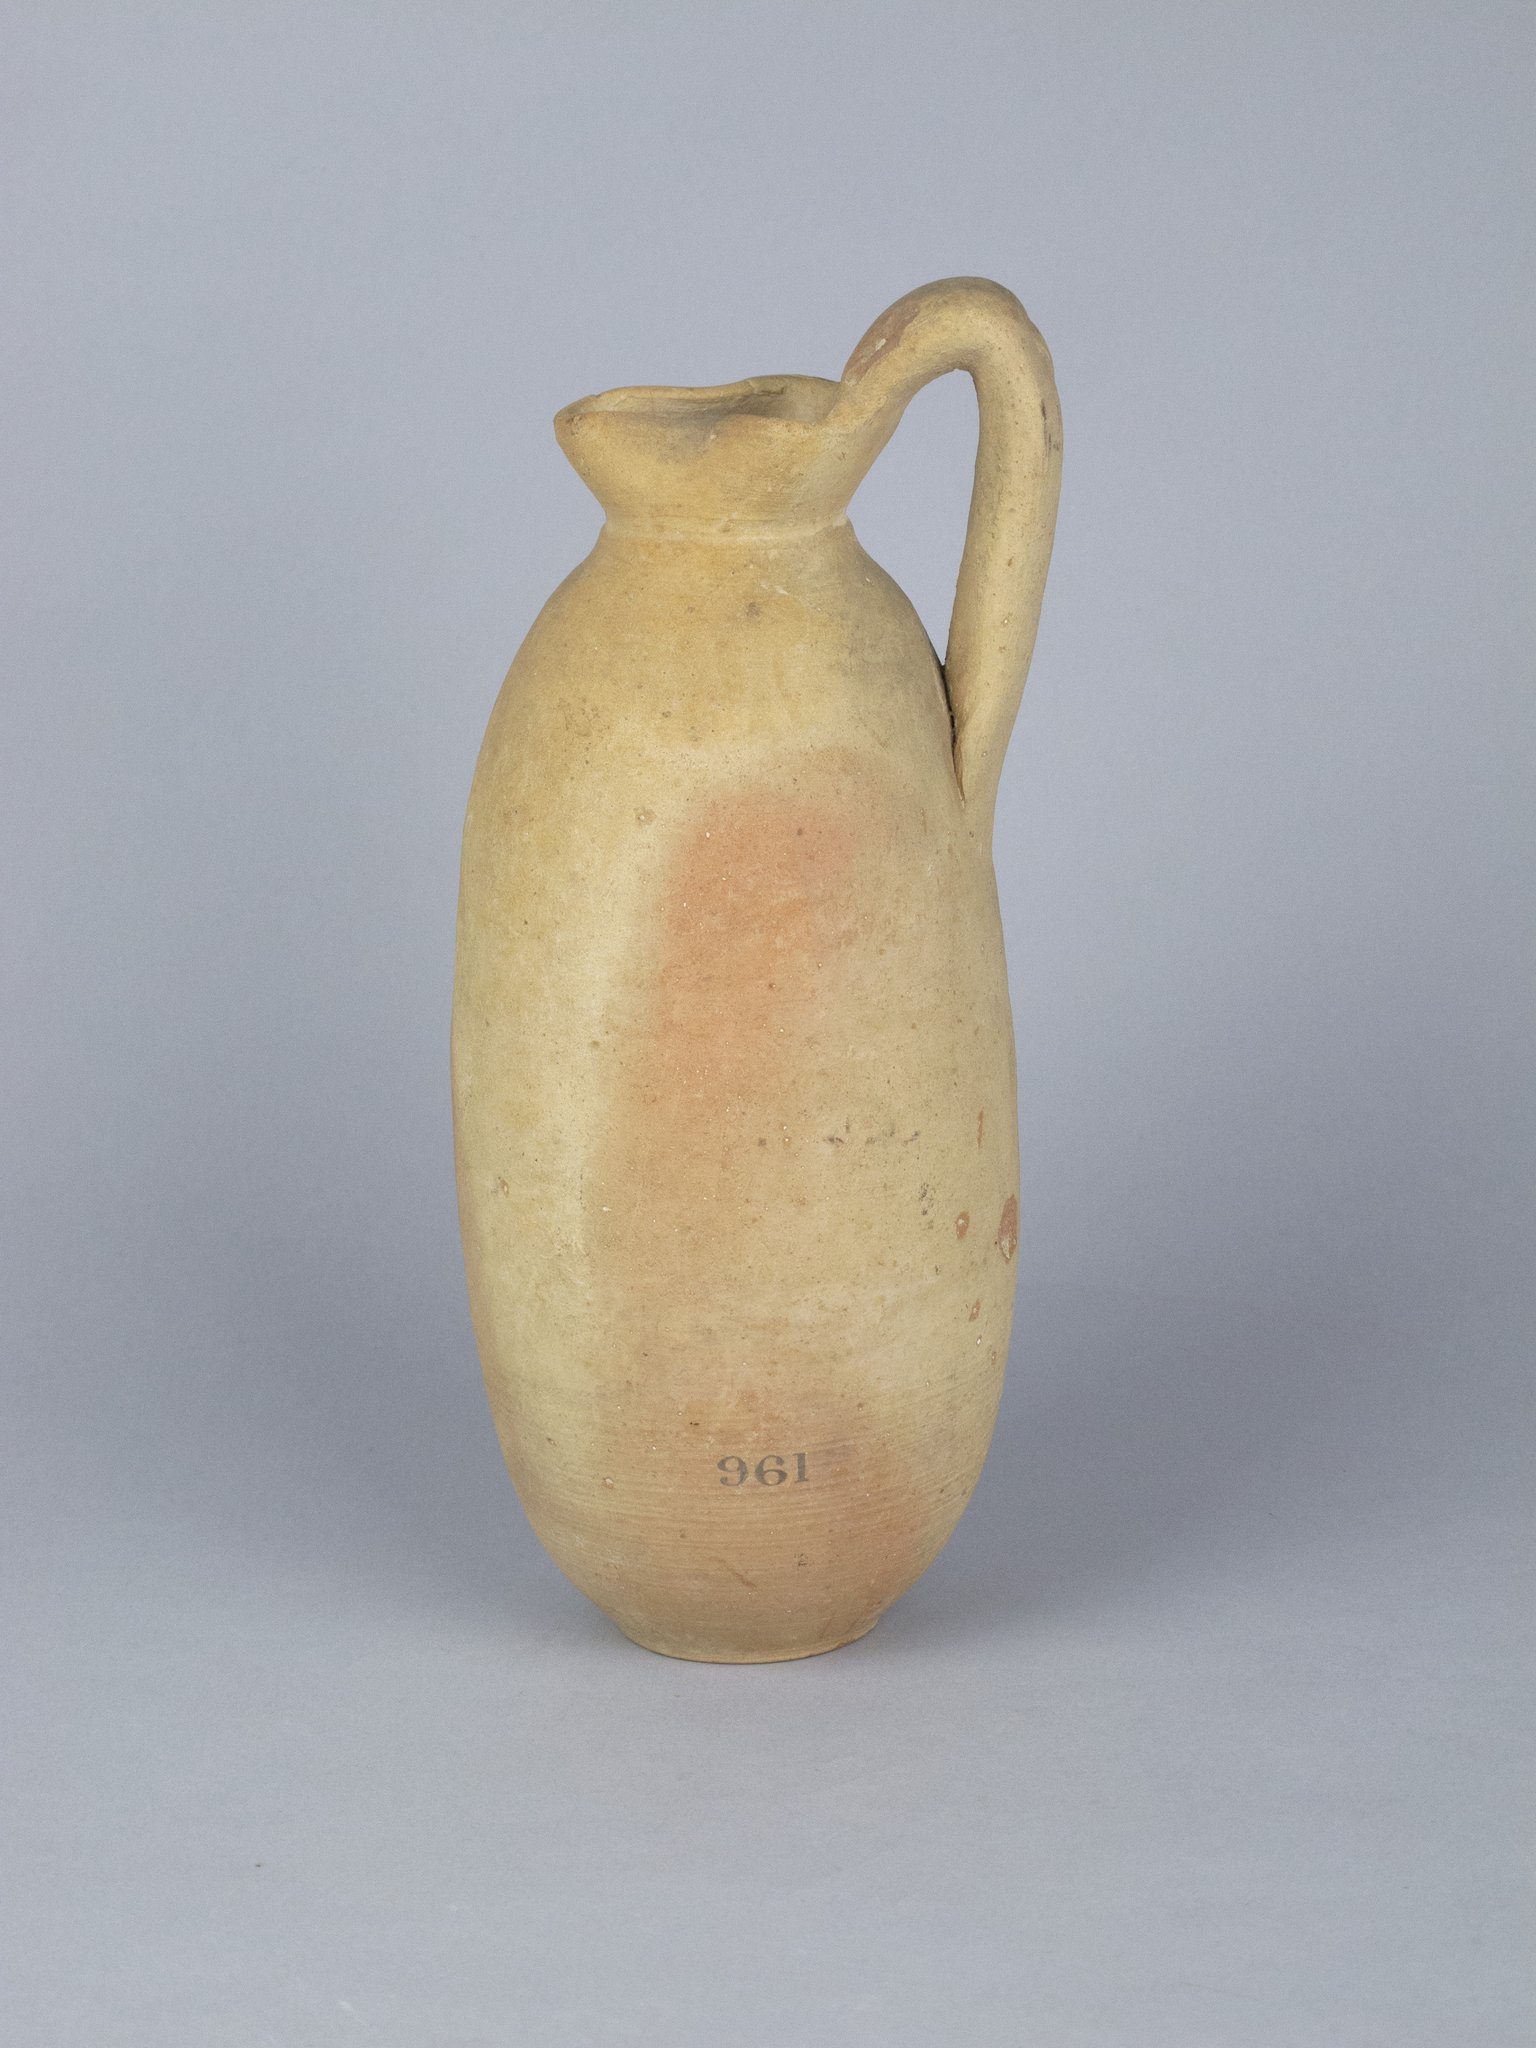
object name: jug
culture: cypriot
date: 600-480 BCE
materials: terracotta